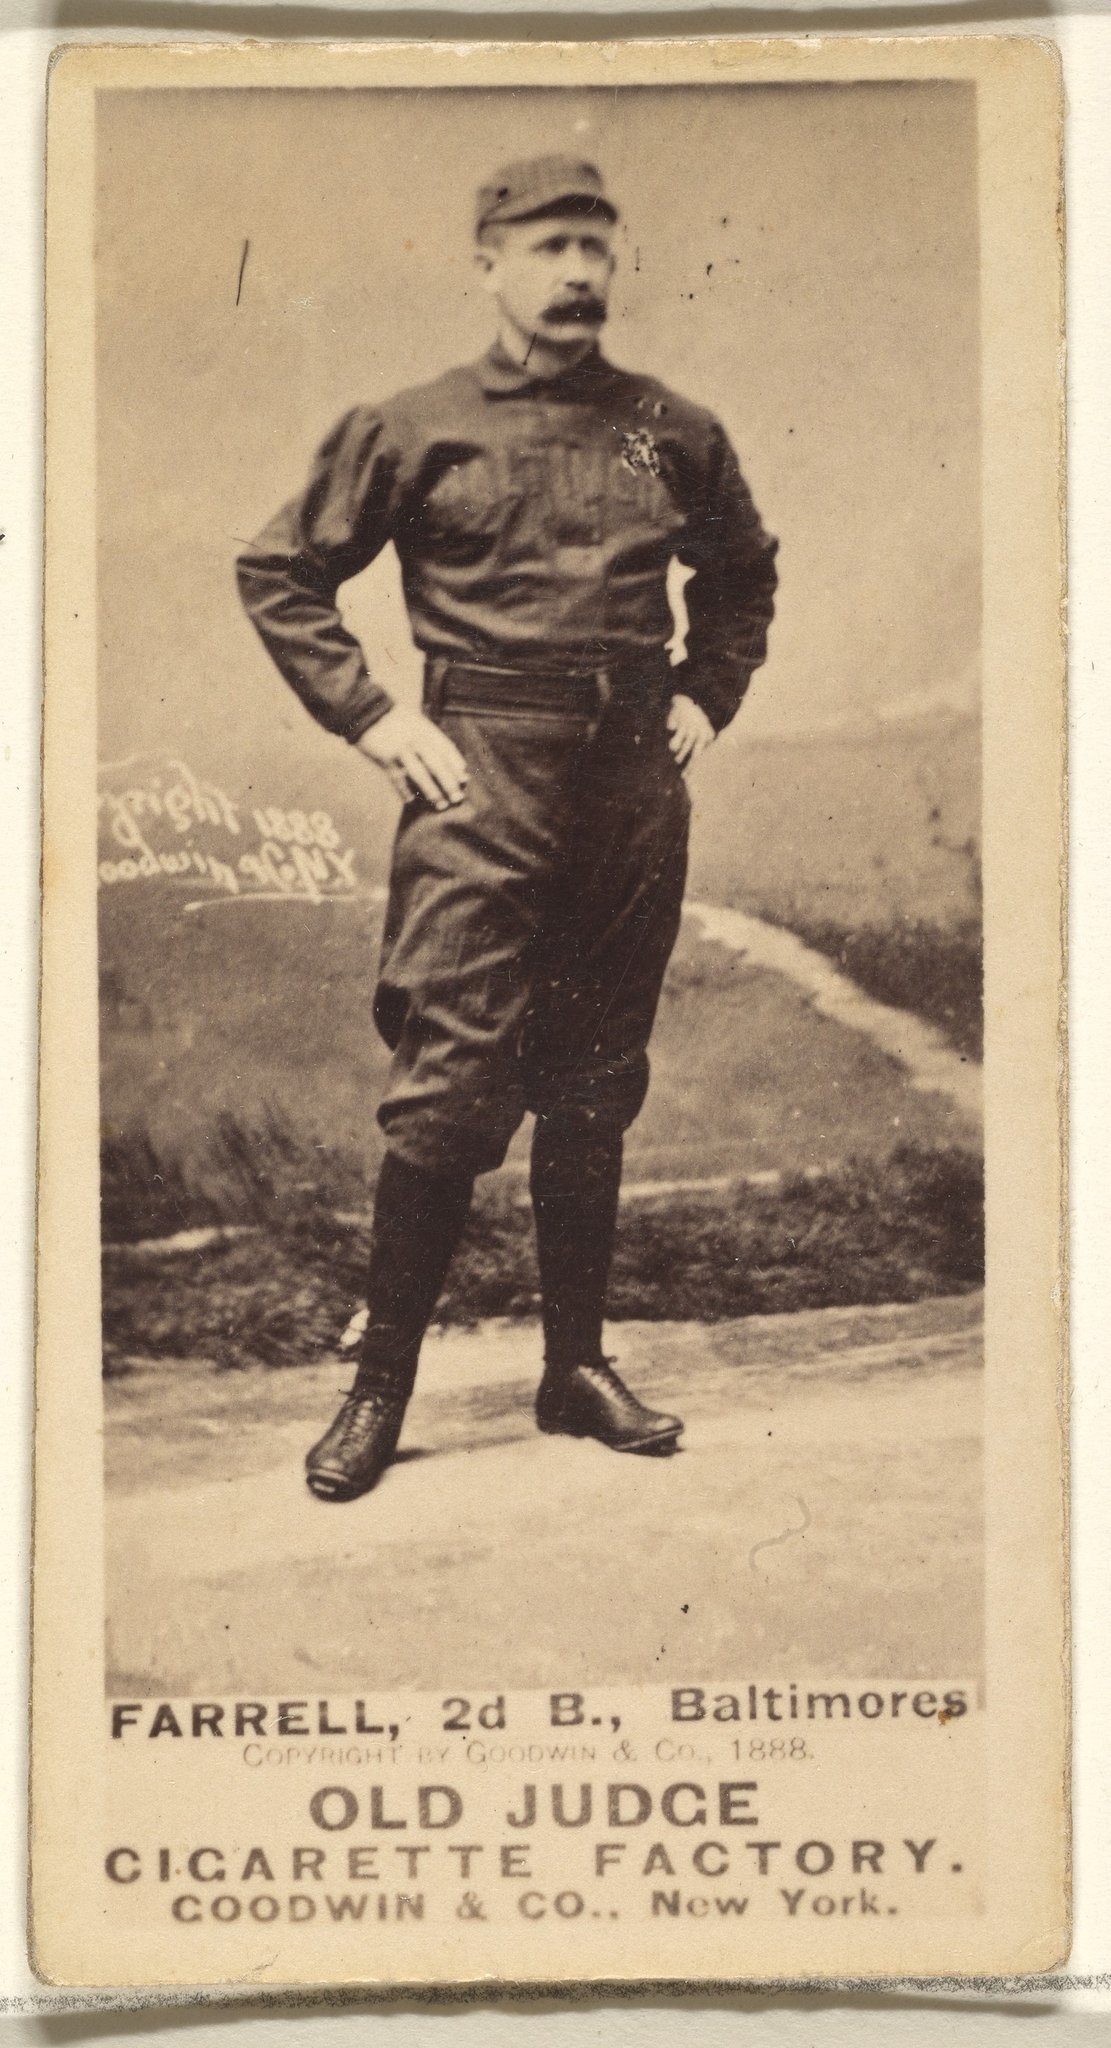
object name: baseball card, photograph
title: Farrell, 2nd Base, Baltimore Orioles, from the Old Judge series (N172) for Old Judge Cigarettes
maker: goodwin & company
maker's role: publisher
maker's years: 1850-1950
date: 1888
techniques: albumen silver print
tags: men,portraits,baseball,athletes